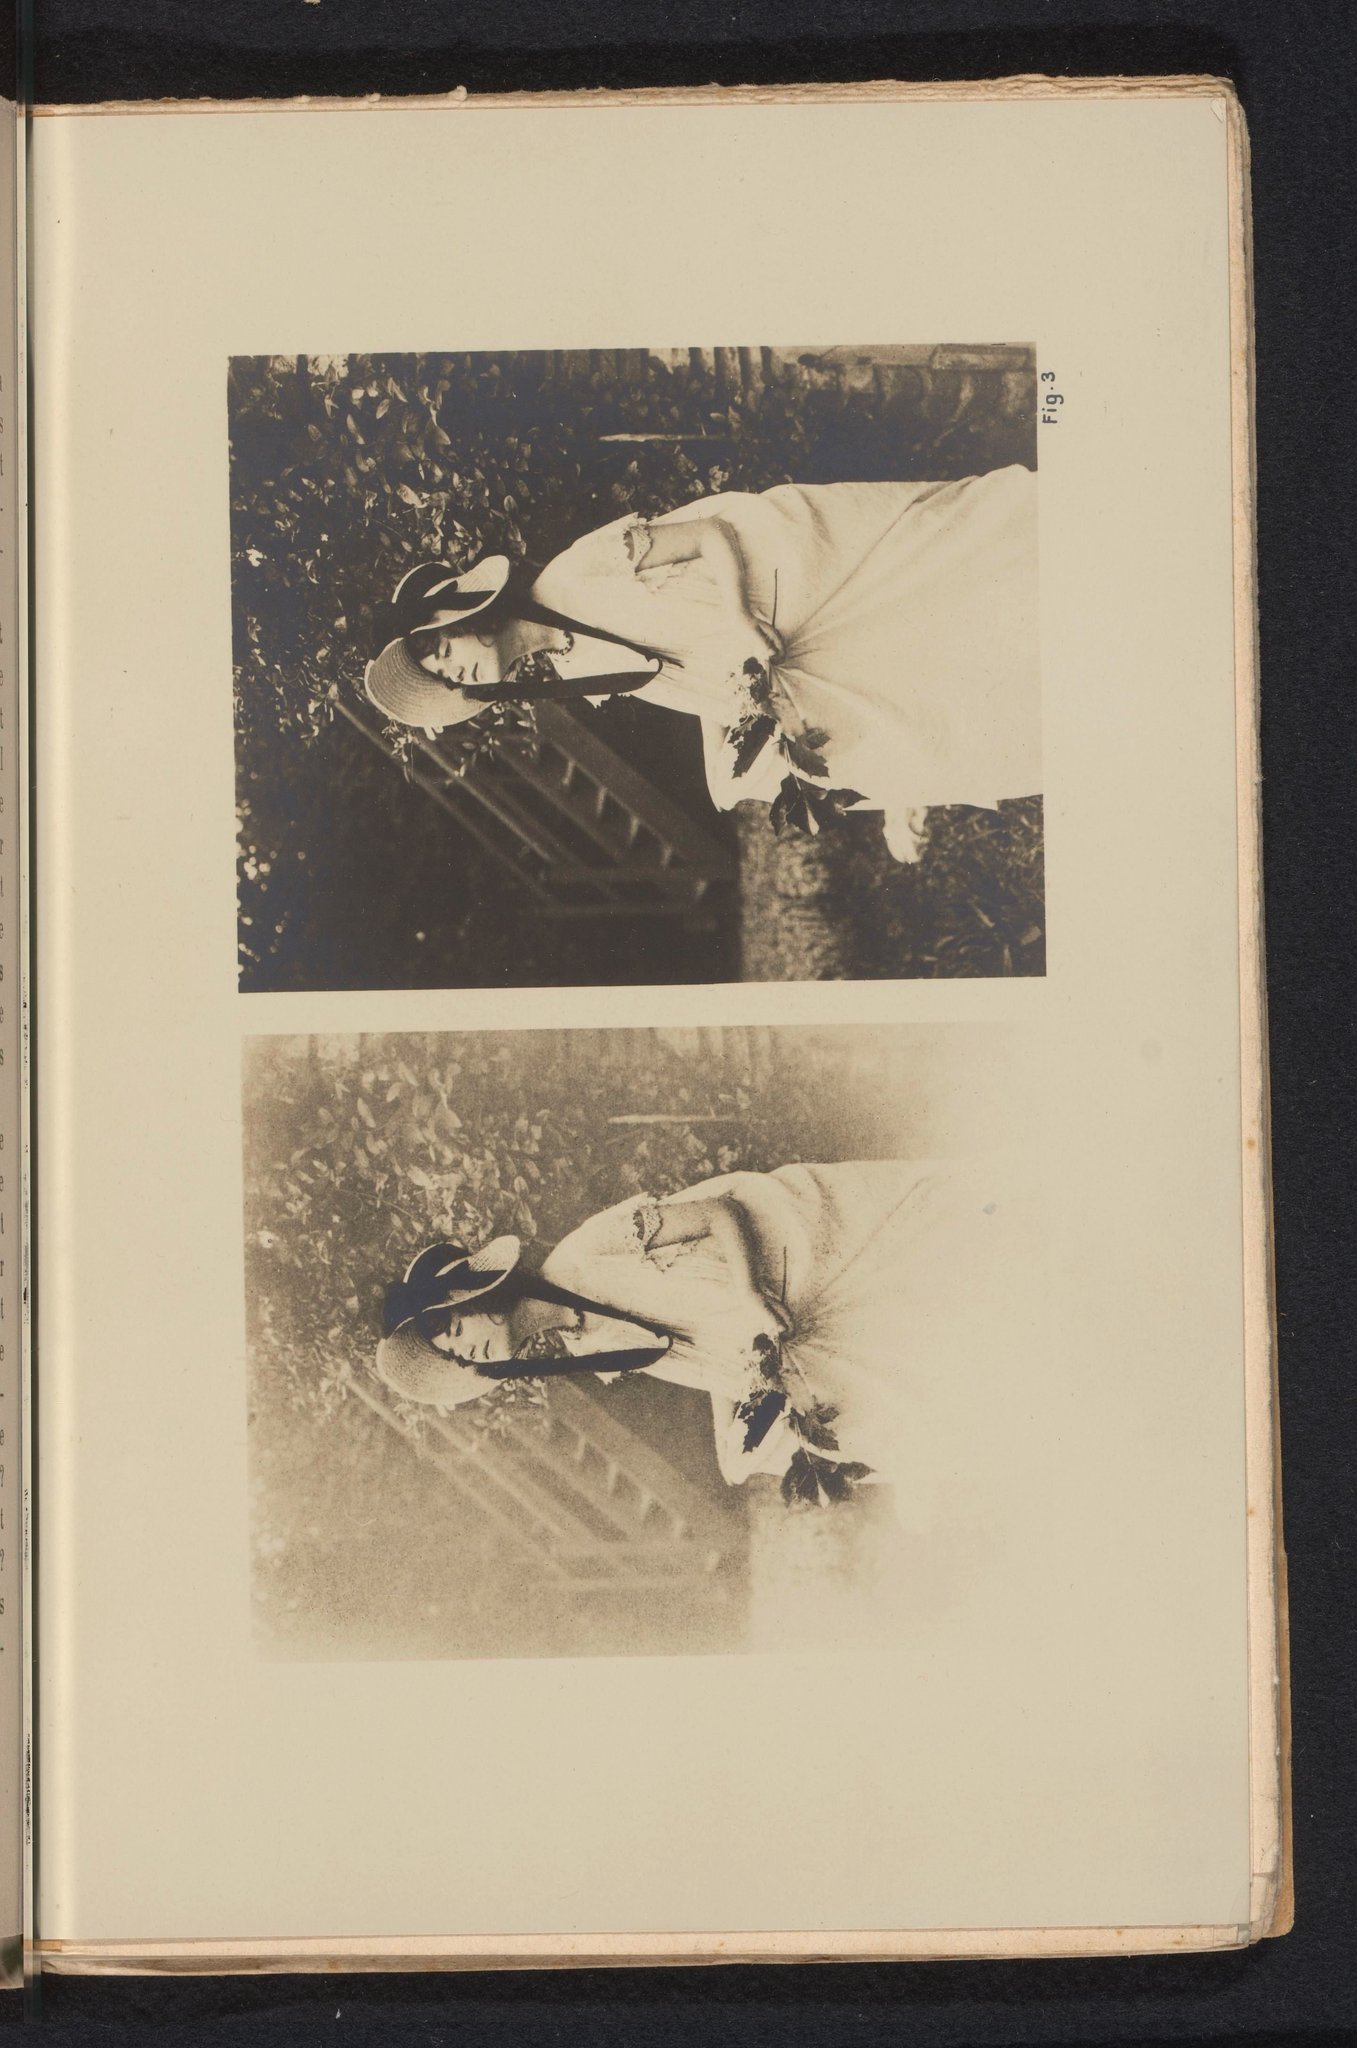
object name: photograph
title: Onbekende vrouw met een tak in de hand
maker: Anonymous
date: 1902-1912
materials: photographic support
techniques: gelatin silver print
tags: shrubs (+ branch, stick), anonymous historical person portrayed - bb - woman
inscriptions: number: ‘Fig. 3’